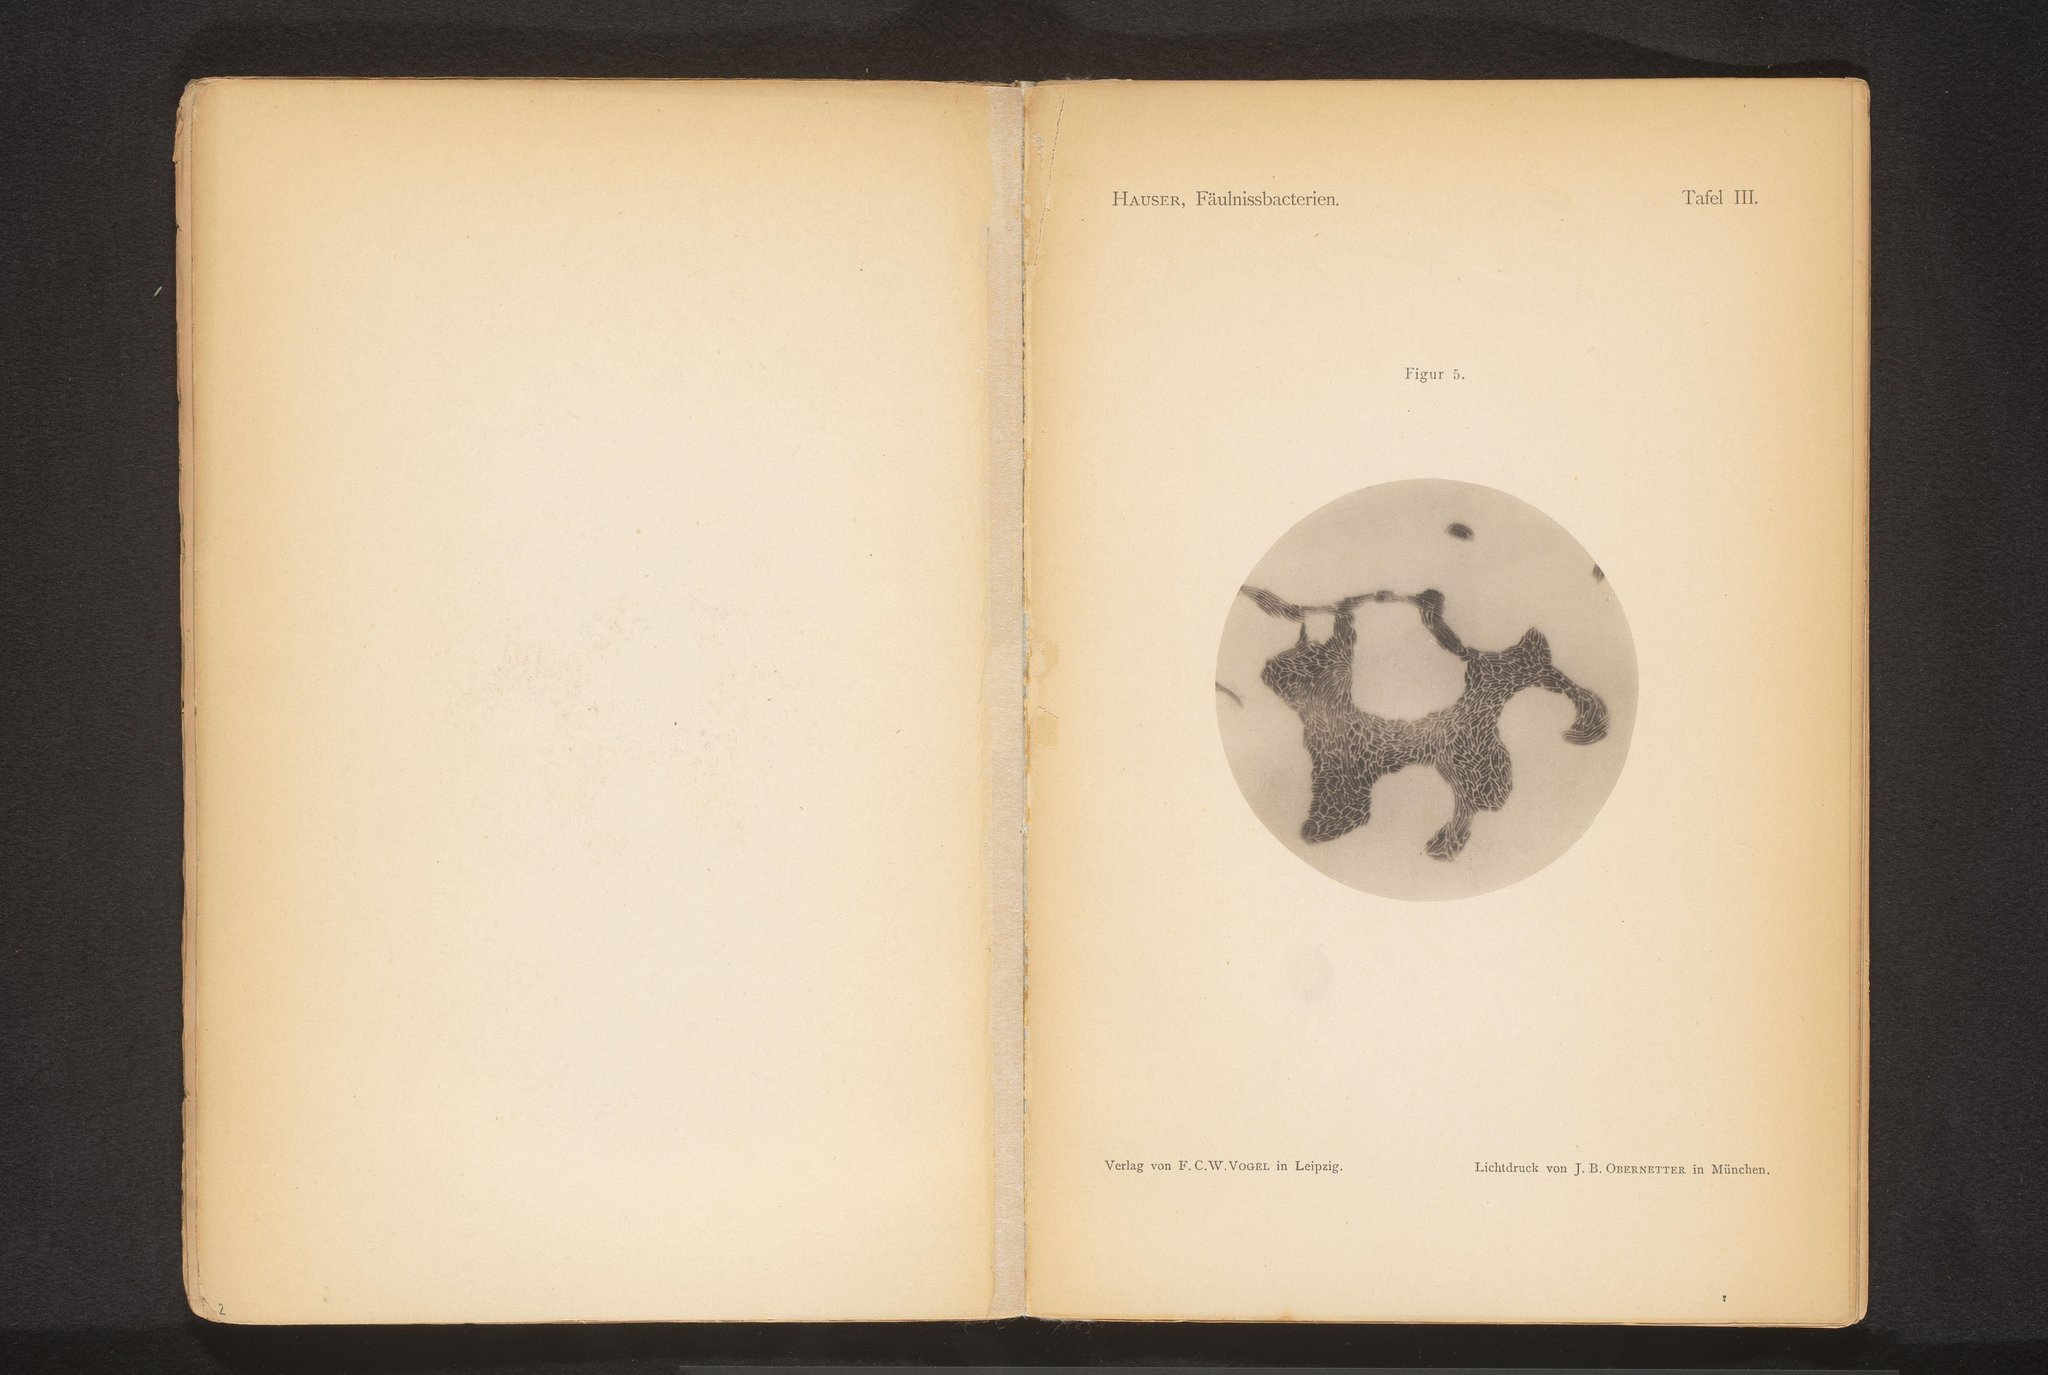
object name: photomechanical print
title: Microscoopopname van bederfbacteriën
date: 1875-1885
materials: paper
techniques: photograph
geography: munich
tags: unicellular animals, bacteria, bacilli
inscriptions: number: ‘Tafel III. Figur 5.’